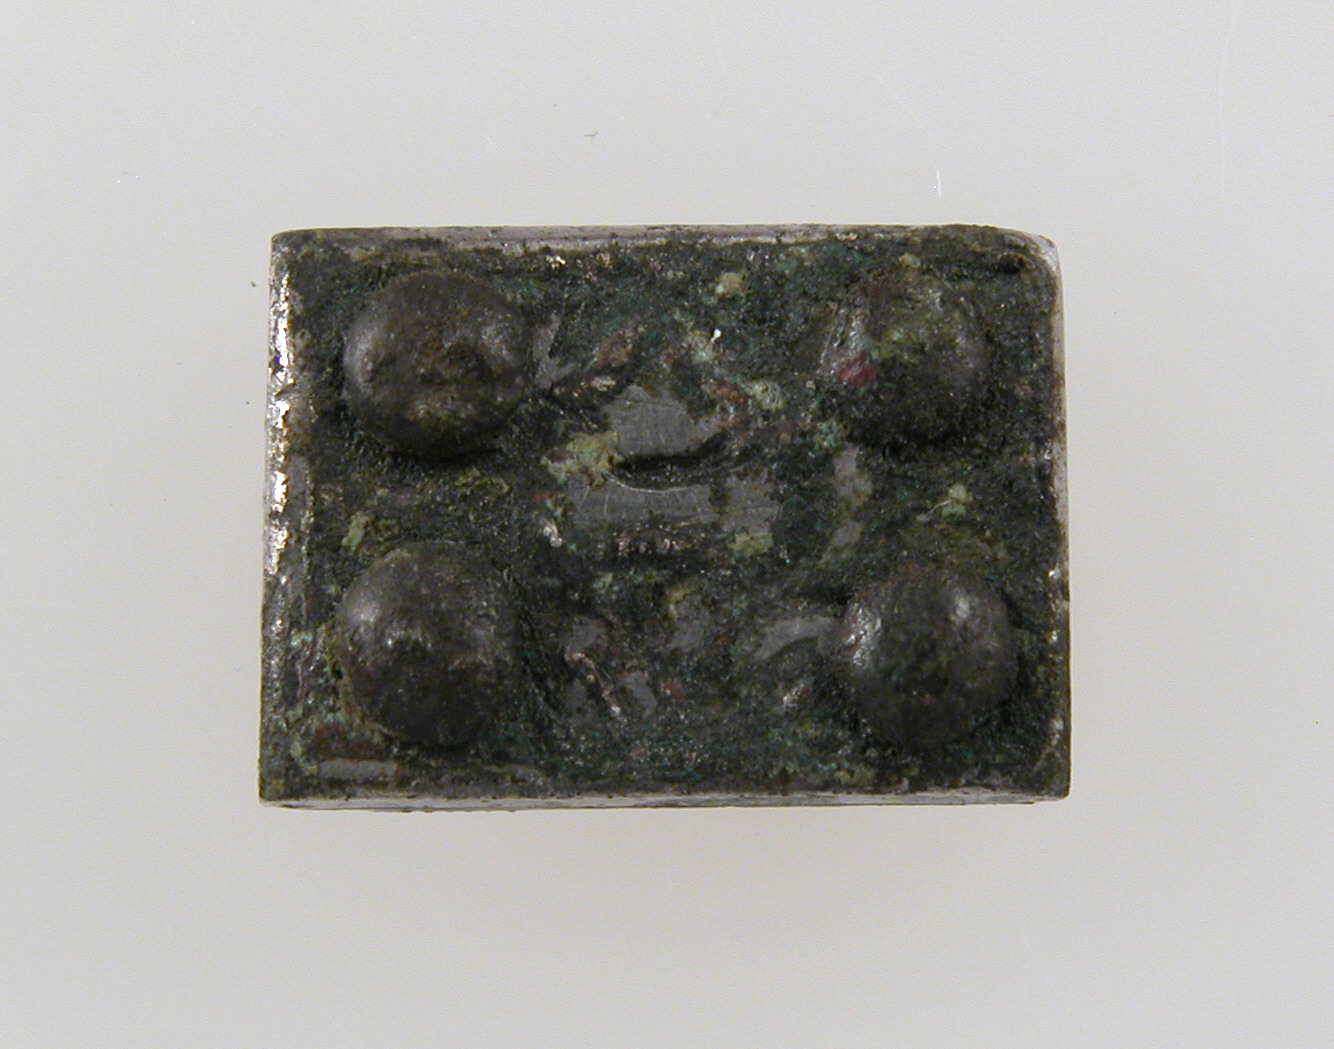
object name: plaque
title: Rectangular Plaque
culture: frankish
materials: copper alloy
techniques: silvered